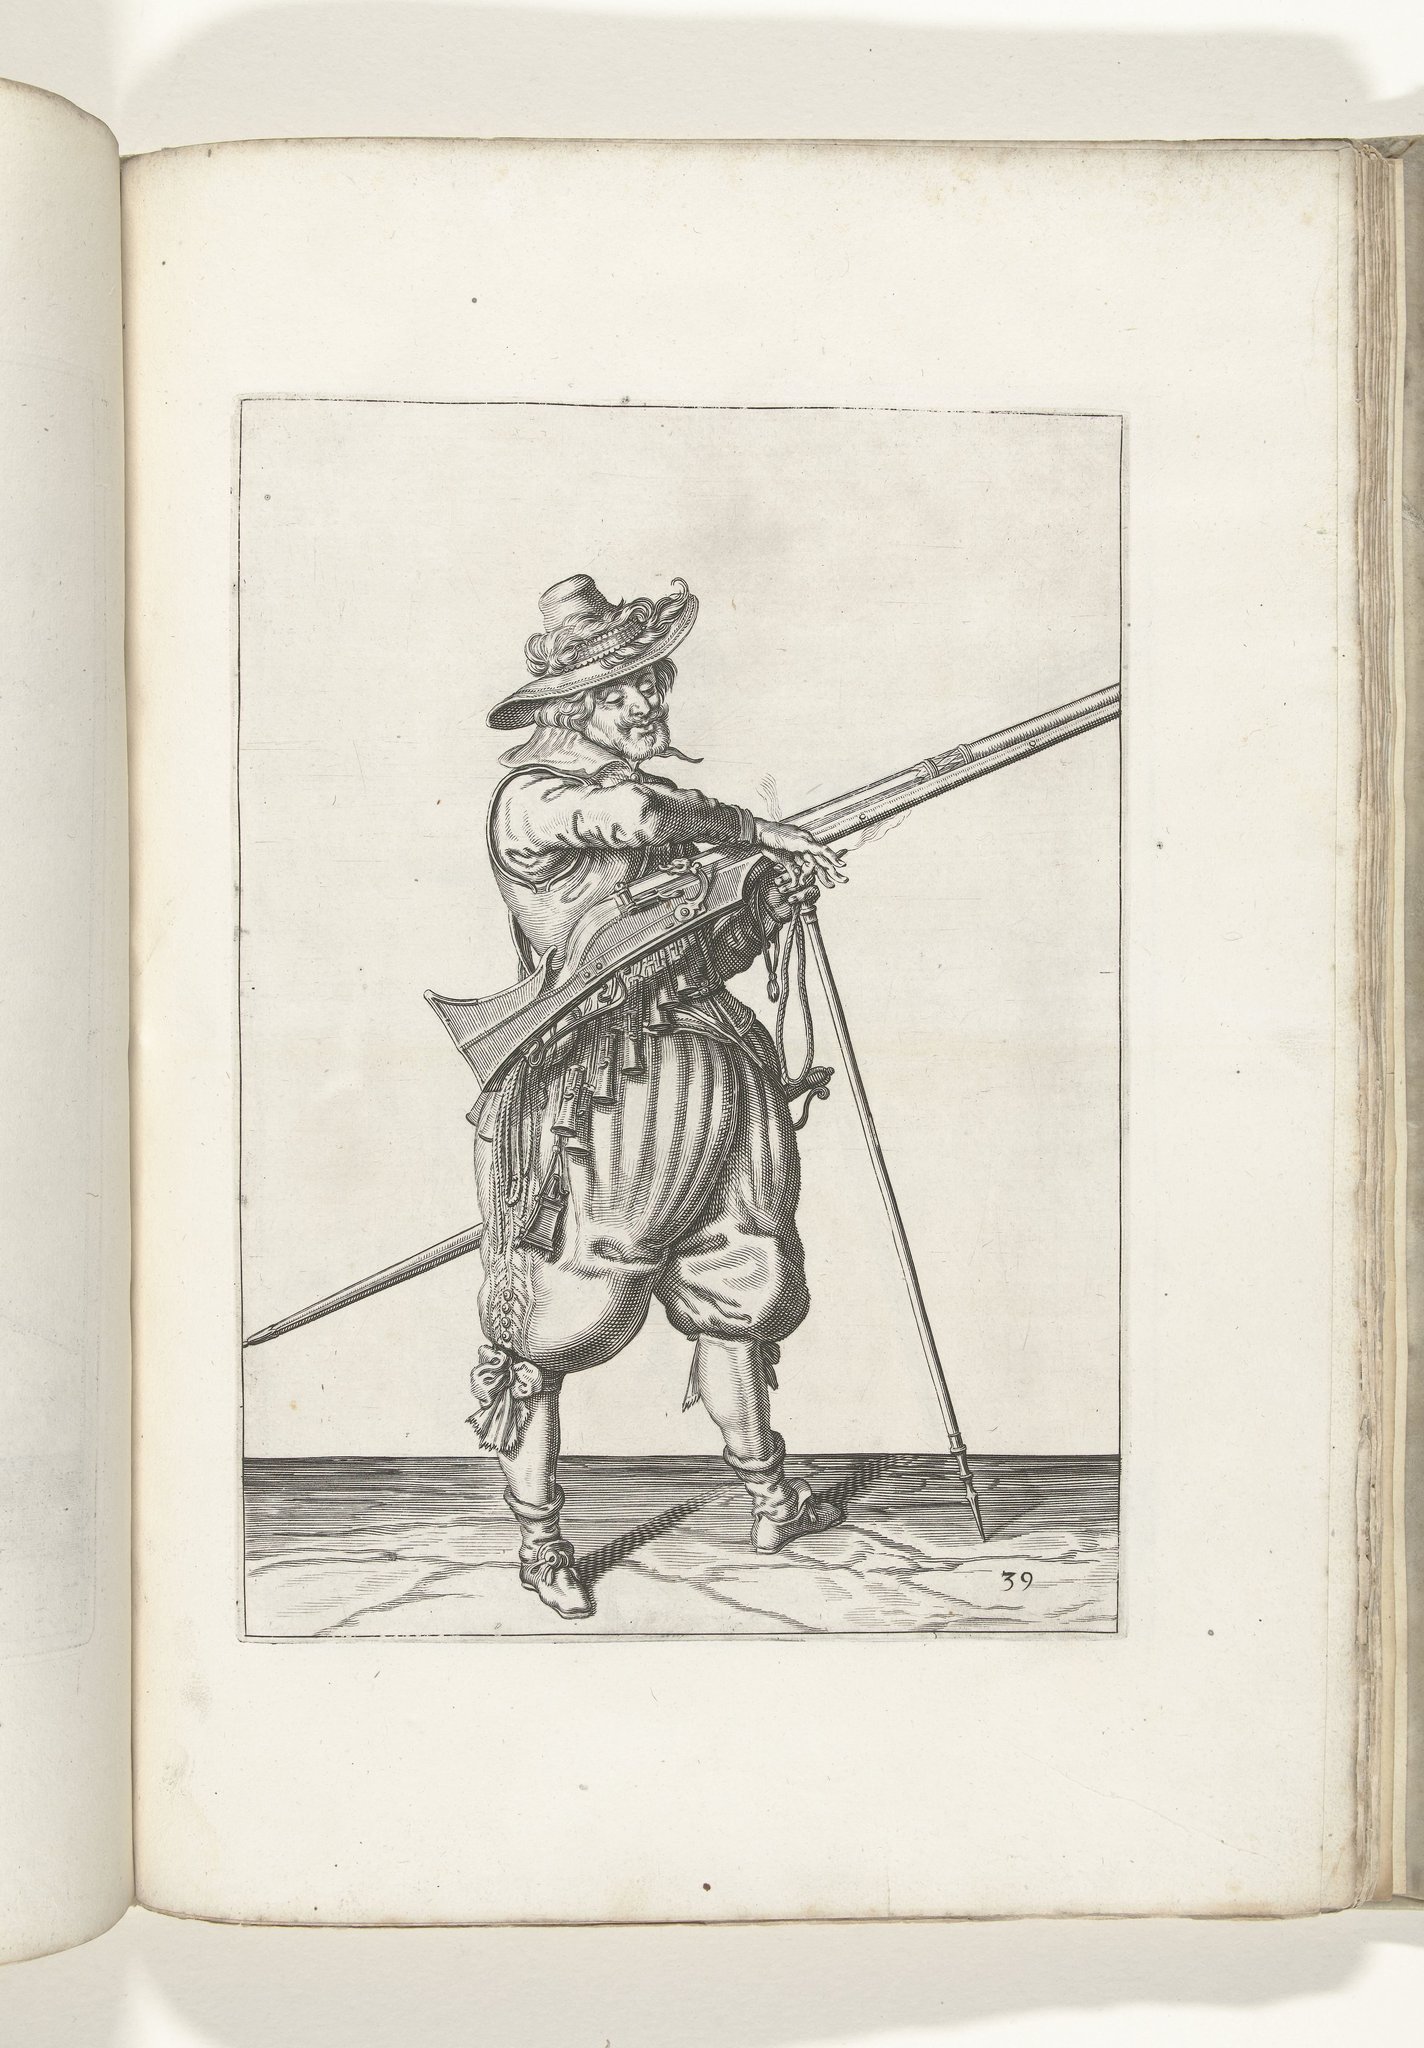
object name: print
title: Soldaat op wacht met een musket die zijn lont pakt (nr. 39), ca. 1600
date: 1597-1607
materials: paper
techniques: engraving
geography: northern netherlands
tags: the hague, maurice (prince of orange), handling of weapons ~ military training, weapons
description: Een soldaat op wacht, ten voeten uit, naar rechts, die een musket (een bepaald type vuurwapen) met zijn linkerhand vasthoudt bij de vork van het furket (musketvork) waar de loop op steunt (nr. 39), ca. 1600. In zijn linkerhand behalve het furket ook een brandende lont. Met zijn rechterhand pakt hij deze lont. Plaat 39 in de instructies voor het hanteren van het musket: Corte onderrechtinghe op de figuerliicke afbeeldinghe, soo veel aengaet het recht ghebruyck vant Musquet. Onderdeel van de illustraties in: J. de Gheyn, Wapenhandelinghe van Roers Musquetten ende spiessen, 's-Gravenhage, 1607. Krijgswezen rond 1600.